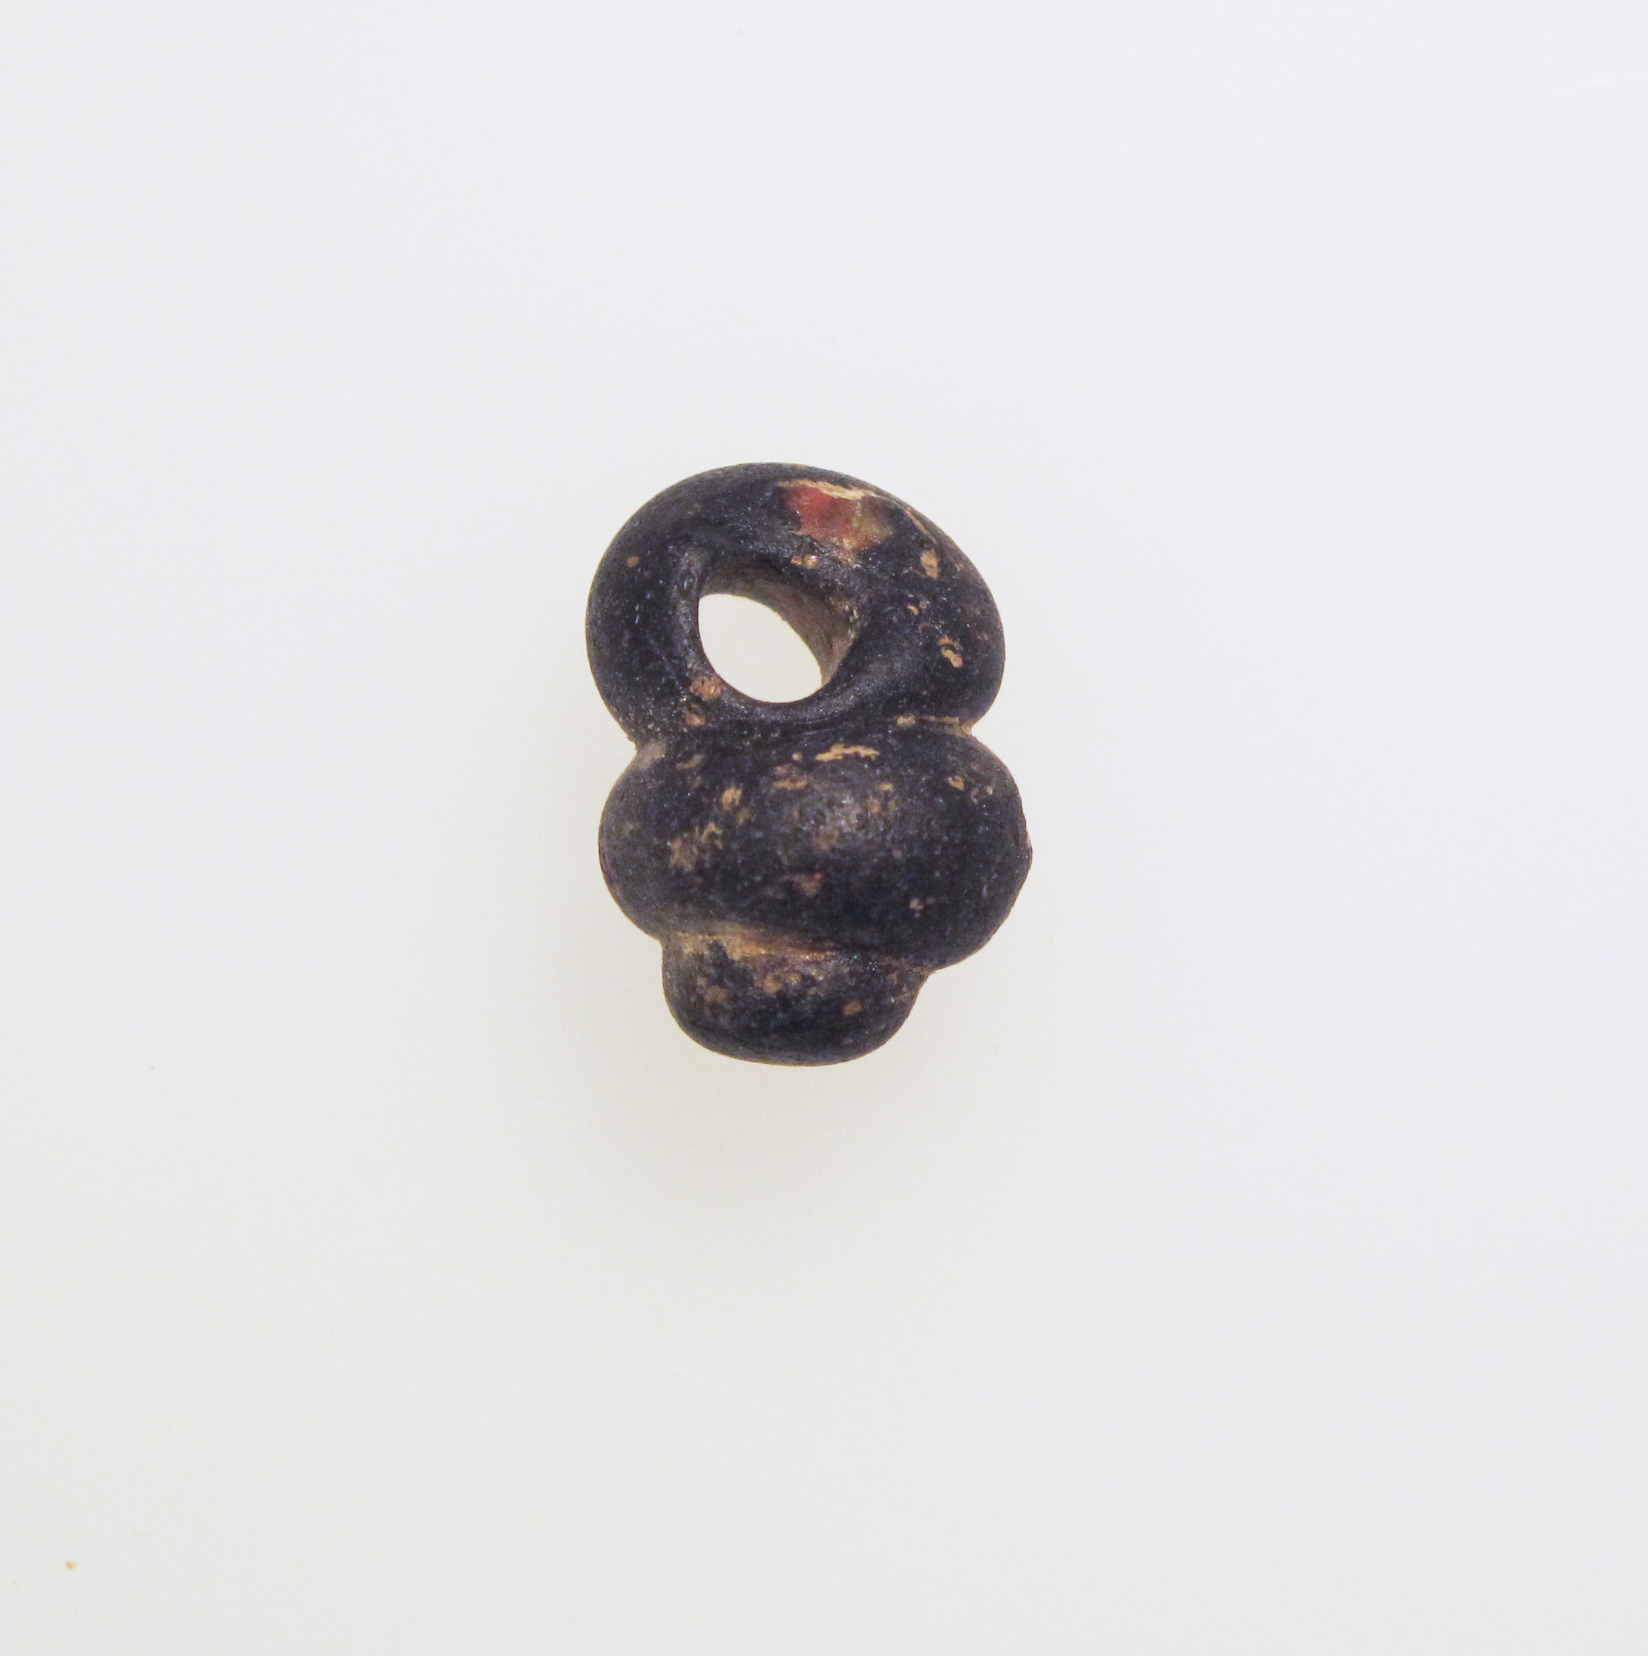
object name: pendant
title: Glass pendant in the form of a jar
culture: roman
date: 201-400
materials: glass